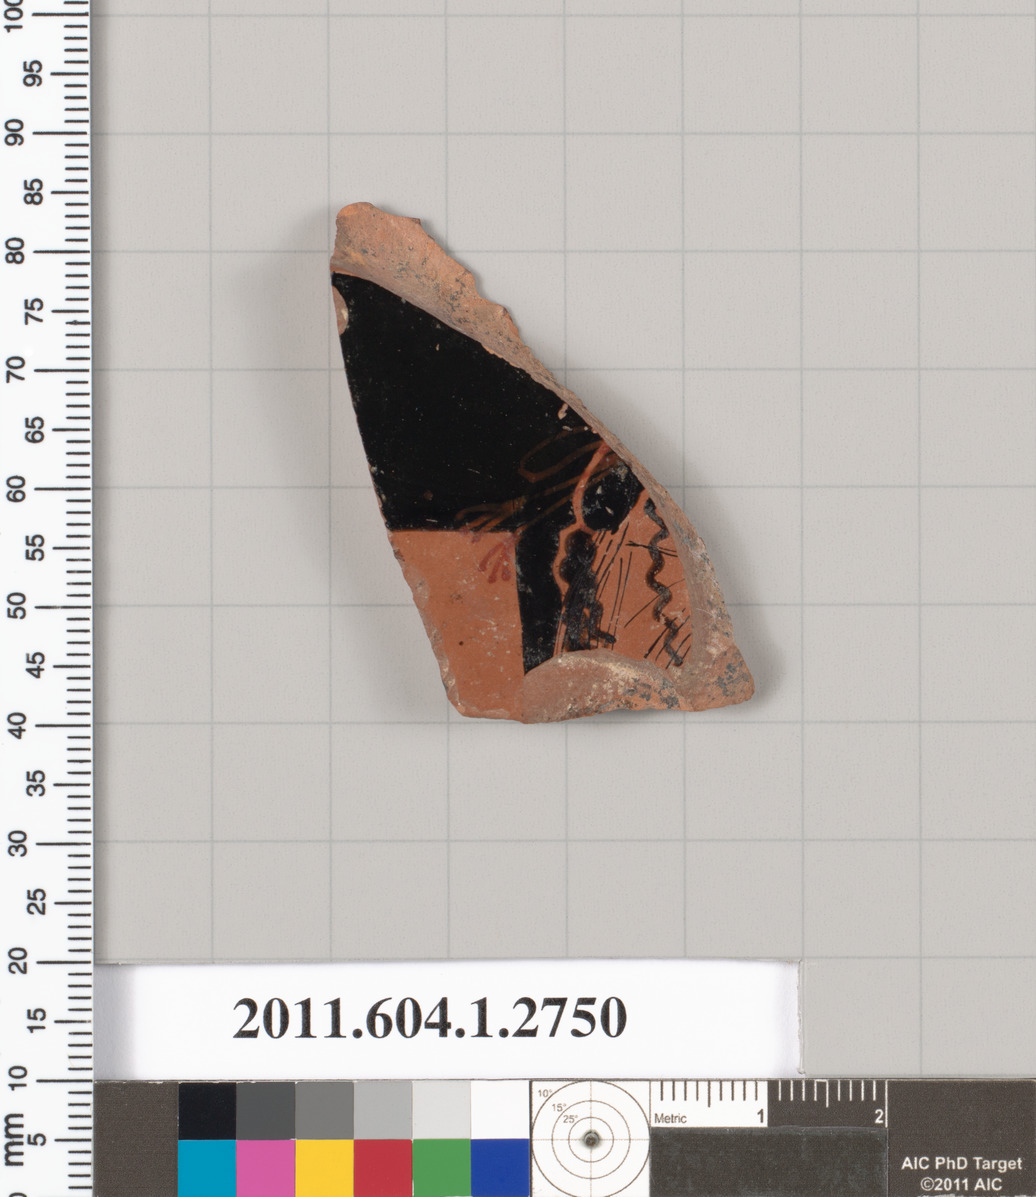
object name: kylix fragment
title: Terracotta fragment of a kylix (drinking cup)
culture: greek, attic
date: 460-450 BCE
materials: terracotta